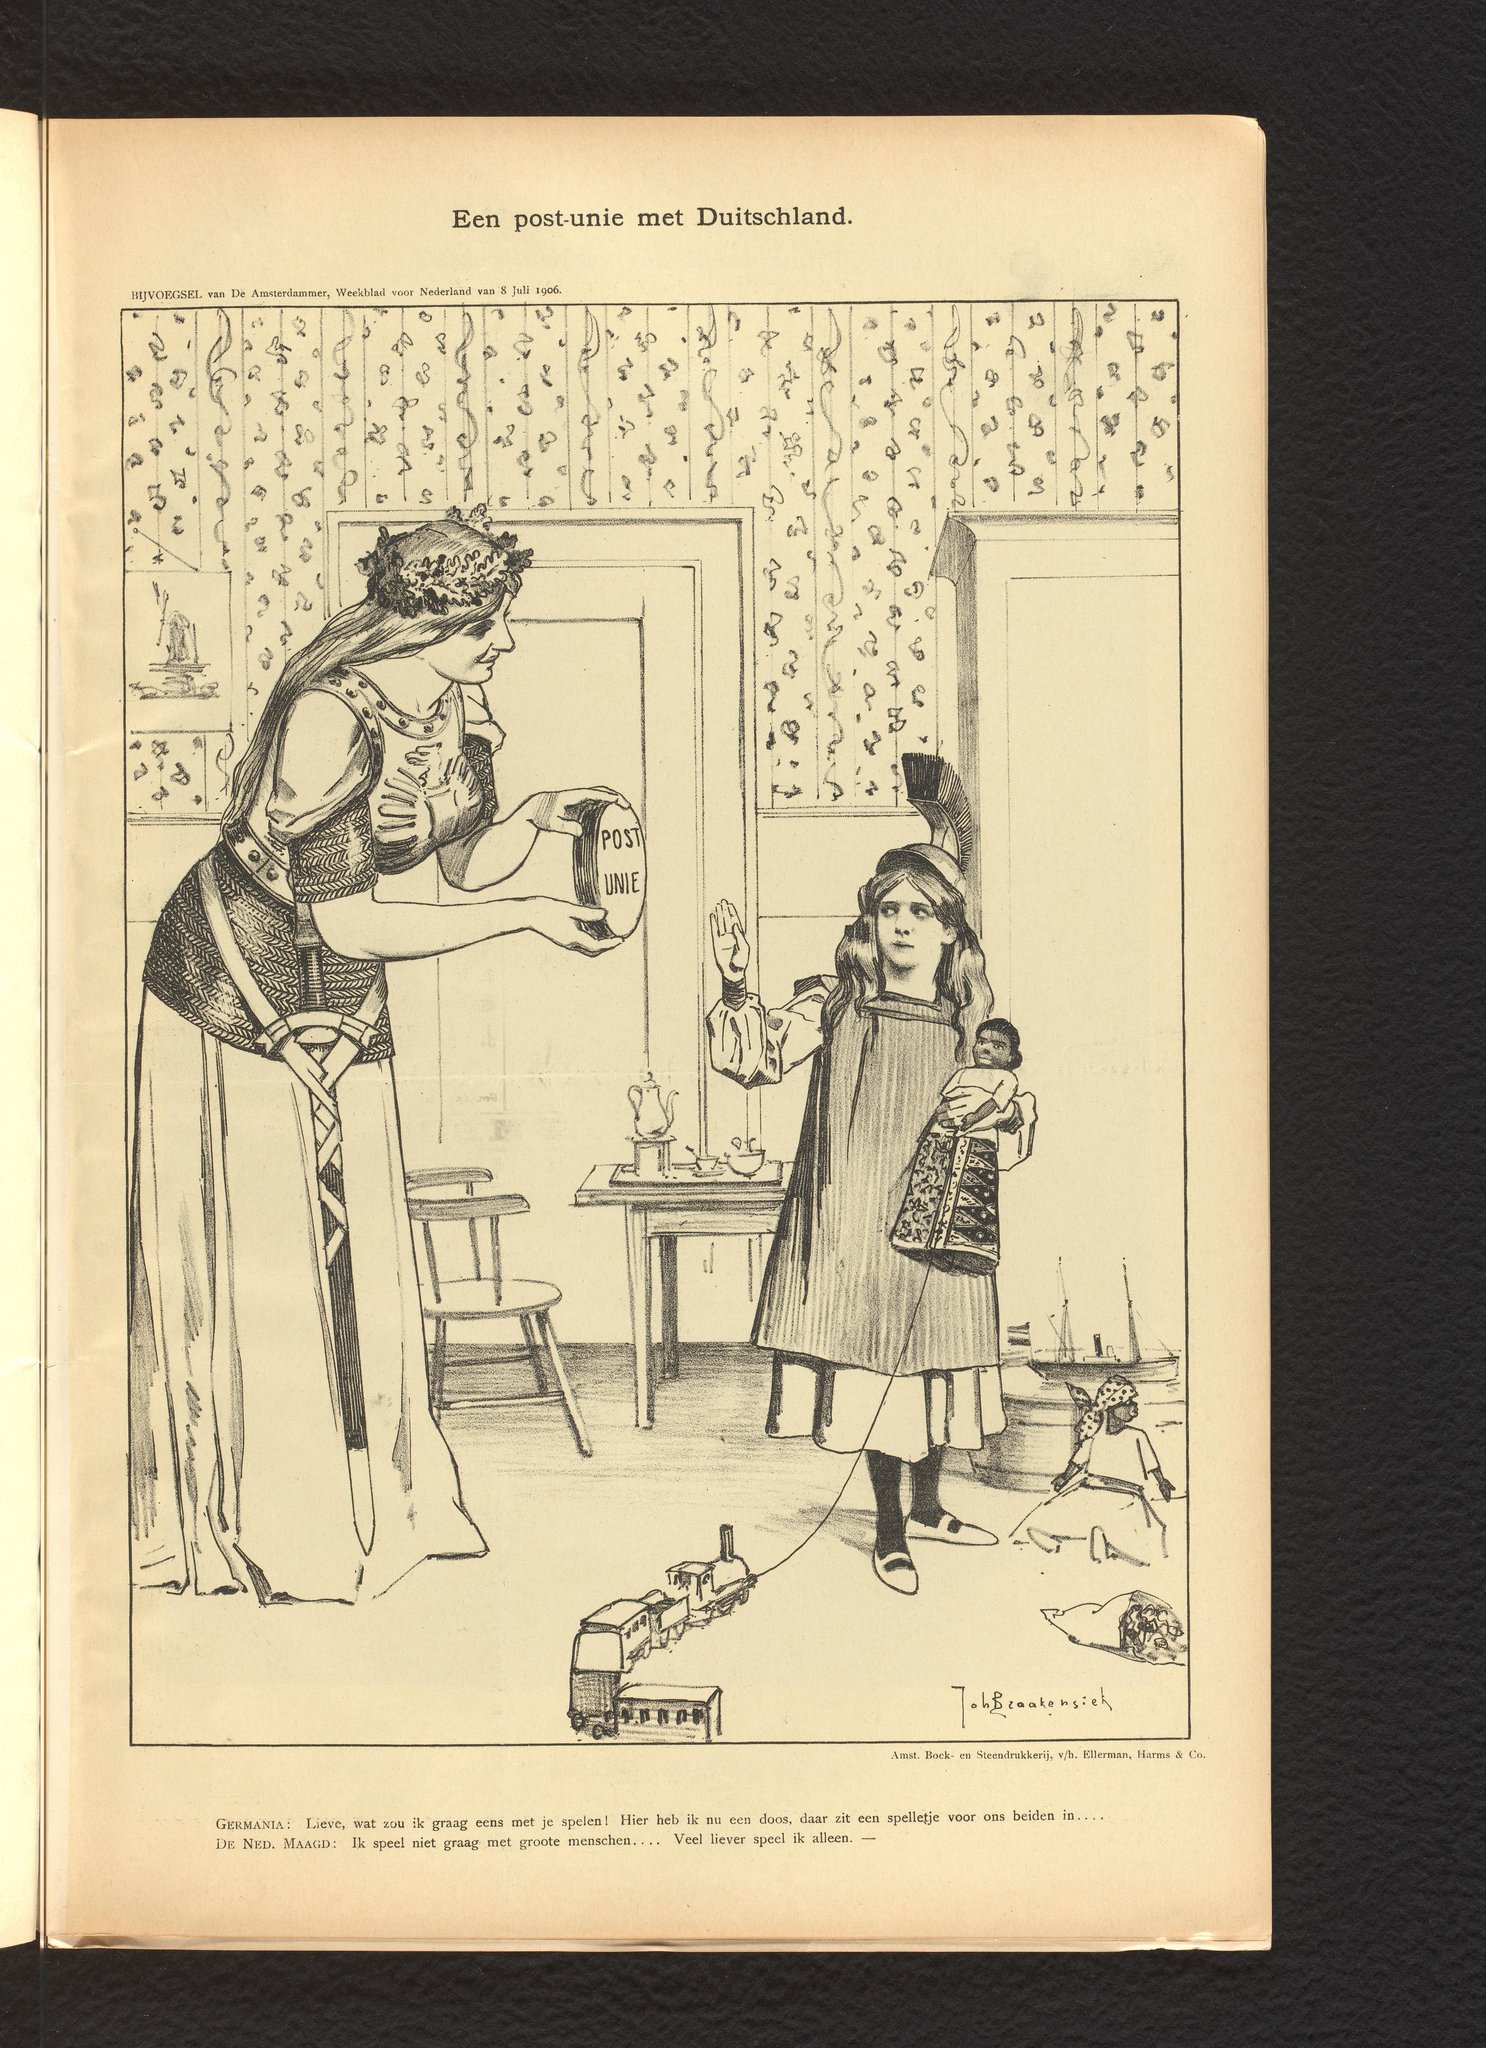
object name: cartoon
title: Een post-unie met Duitschland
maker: johan braakensiek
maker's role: draughtsman, print maker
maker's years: 1858-1940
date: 1906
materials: paper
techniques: lithograph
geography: netherlands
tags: personifications of countries, nations, states, districts, etc., (playing with) dolls, (playing with) toys, political caricatures and satires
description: Germania (Duitsland) wil de Nederlandse Maagd, als meisje, een doos (de postunie) geven om mee te spelen. Nederland wil echter liever alleen met haar eigen speelgoed (Indonesische en Surinaamse poppen, speelgoed trein) blijven spelen.